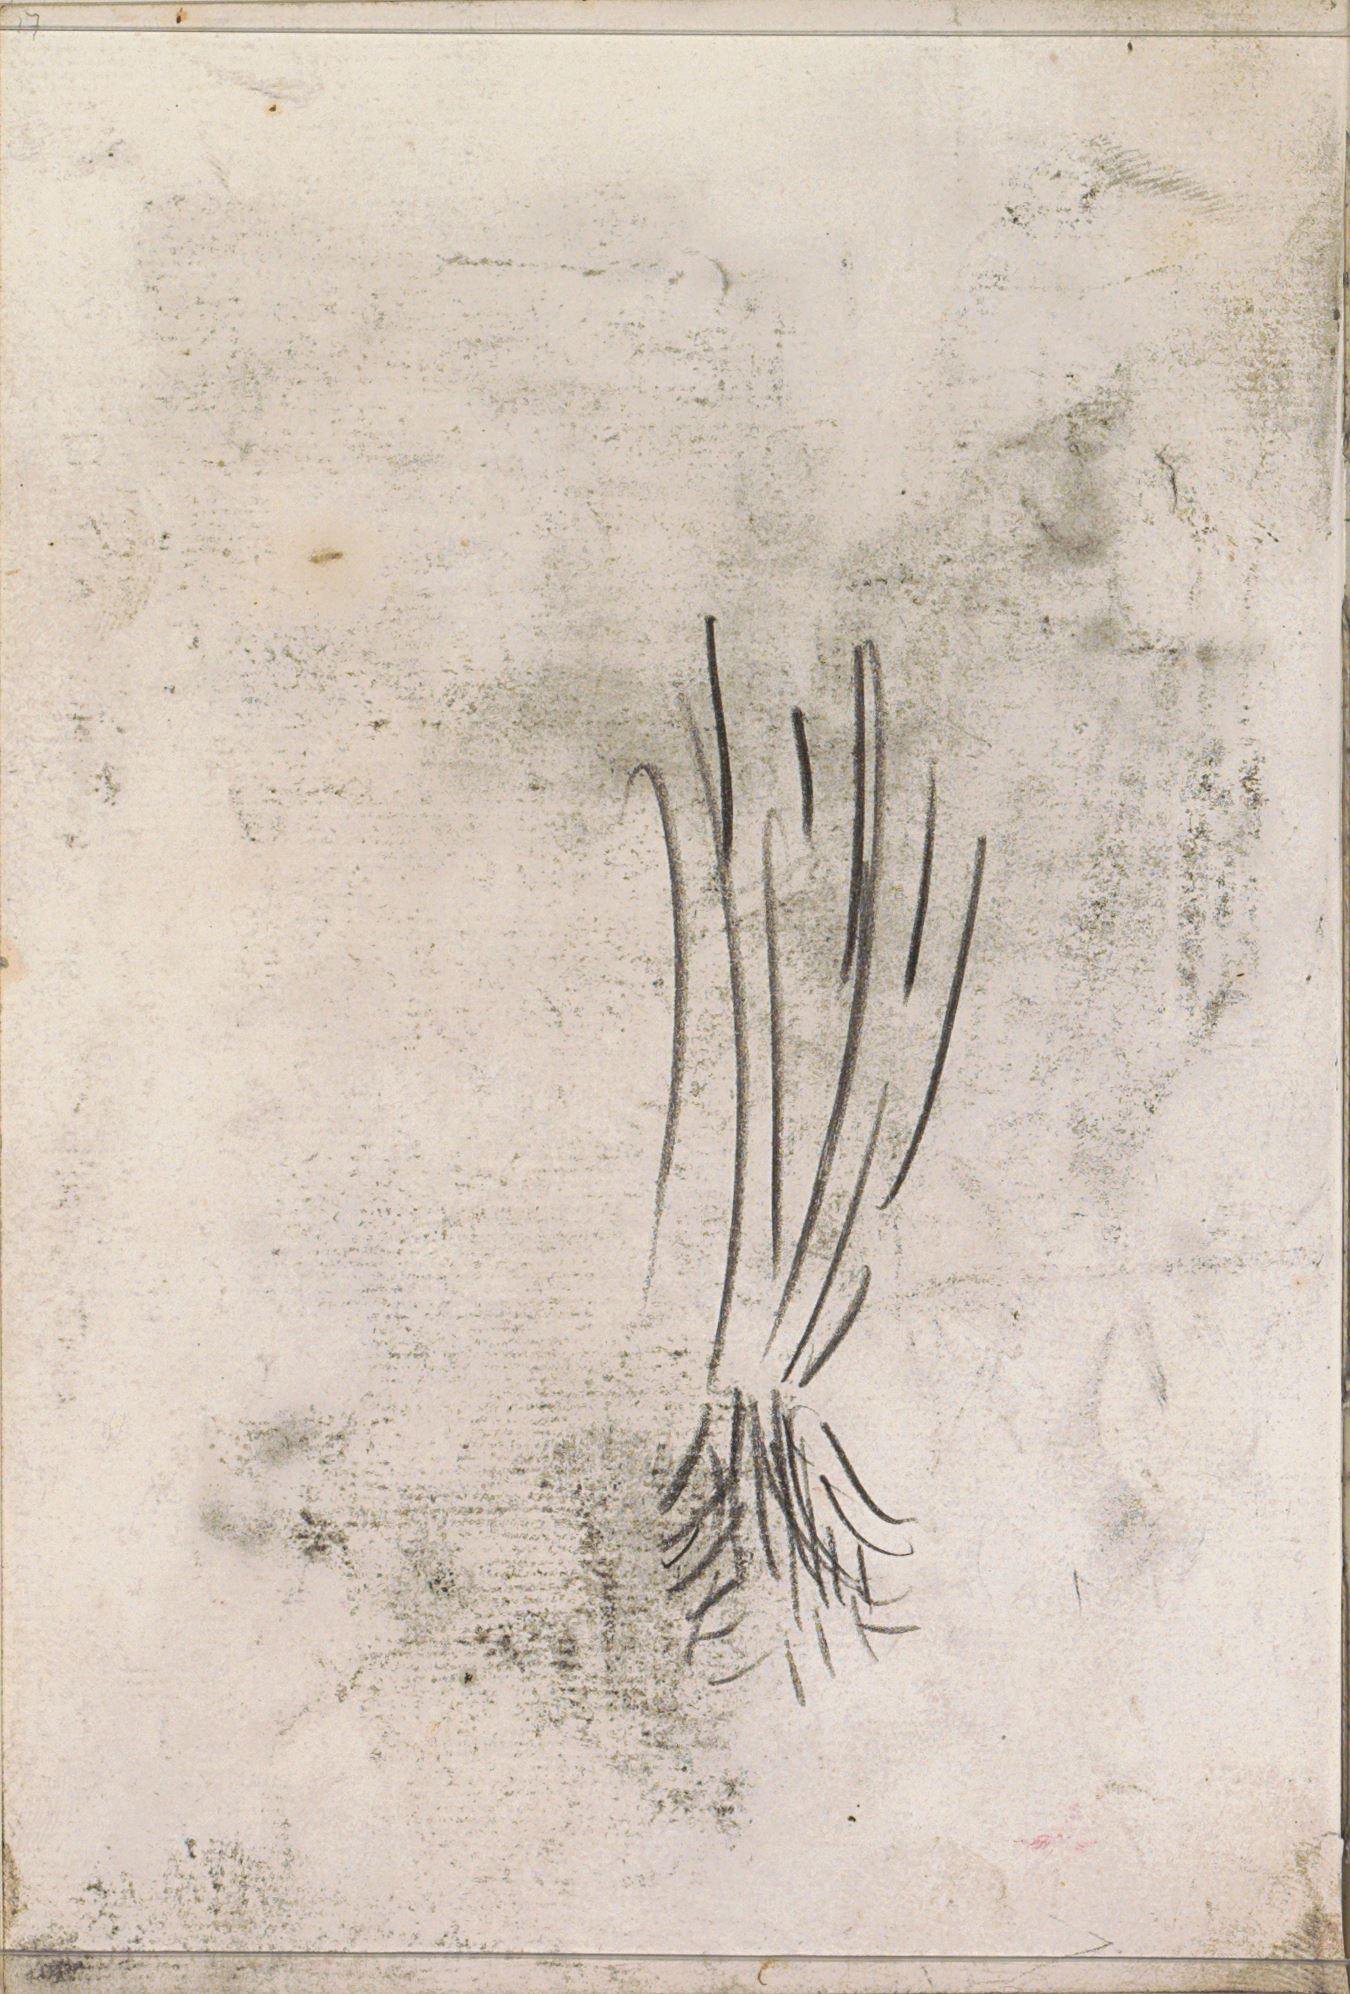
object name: sketchbook leaf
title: Studie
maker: isaac israels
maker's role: draughtsman, painter, print maker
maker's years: 1865-1934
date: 1875-1934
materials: chalk, paper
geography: the hague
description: Pagina 17 uit schetsboek XLIV met 43 pagina's.